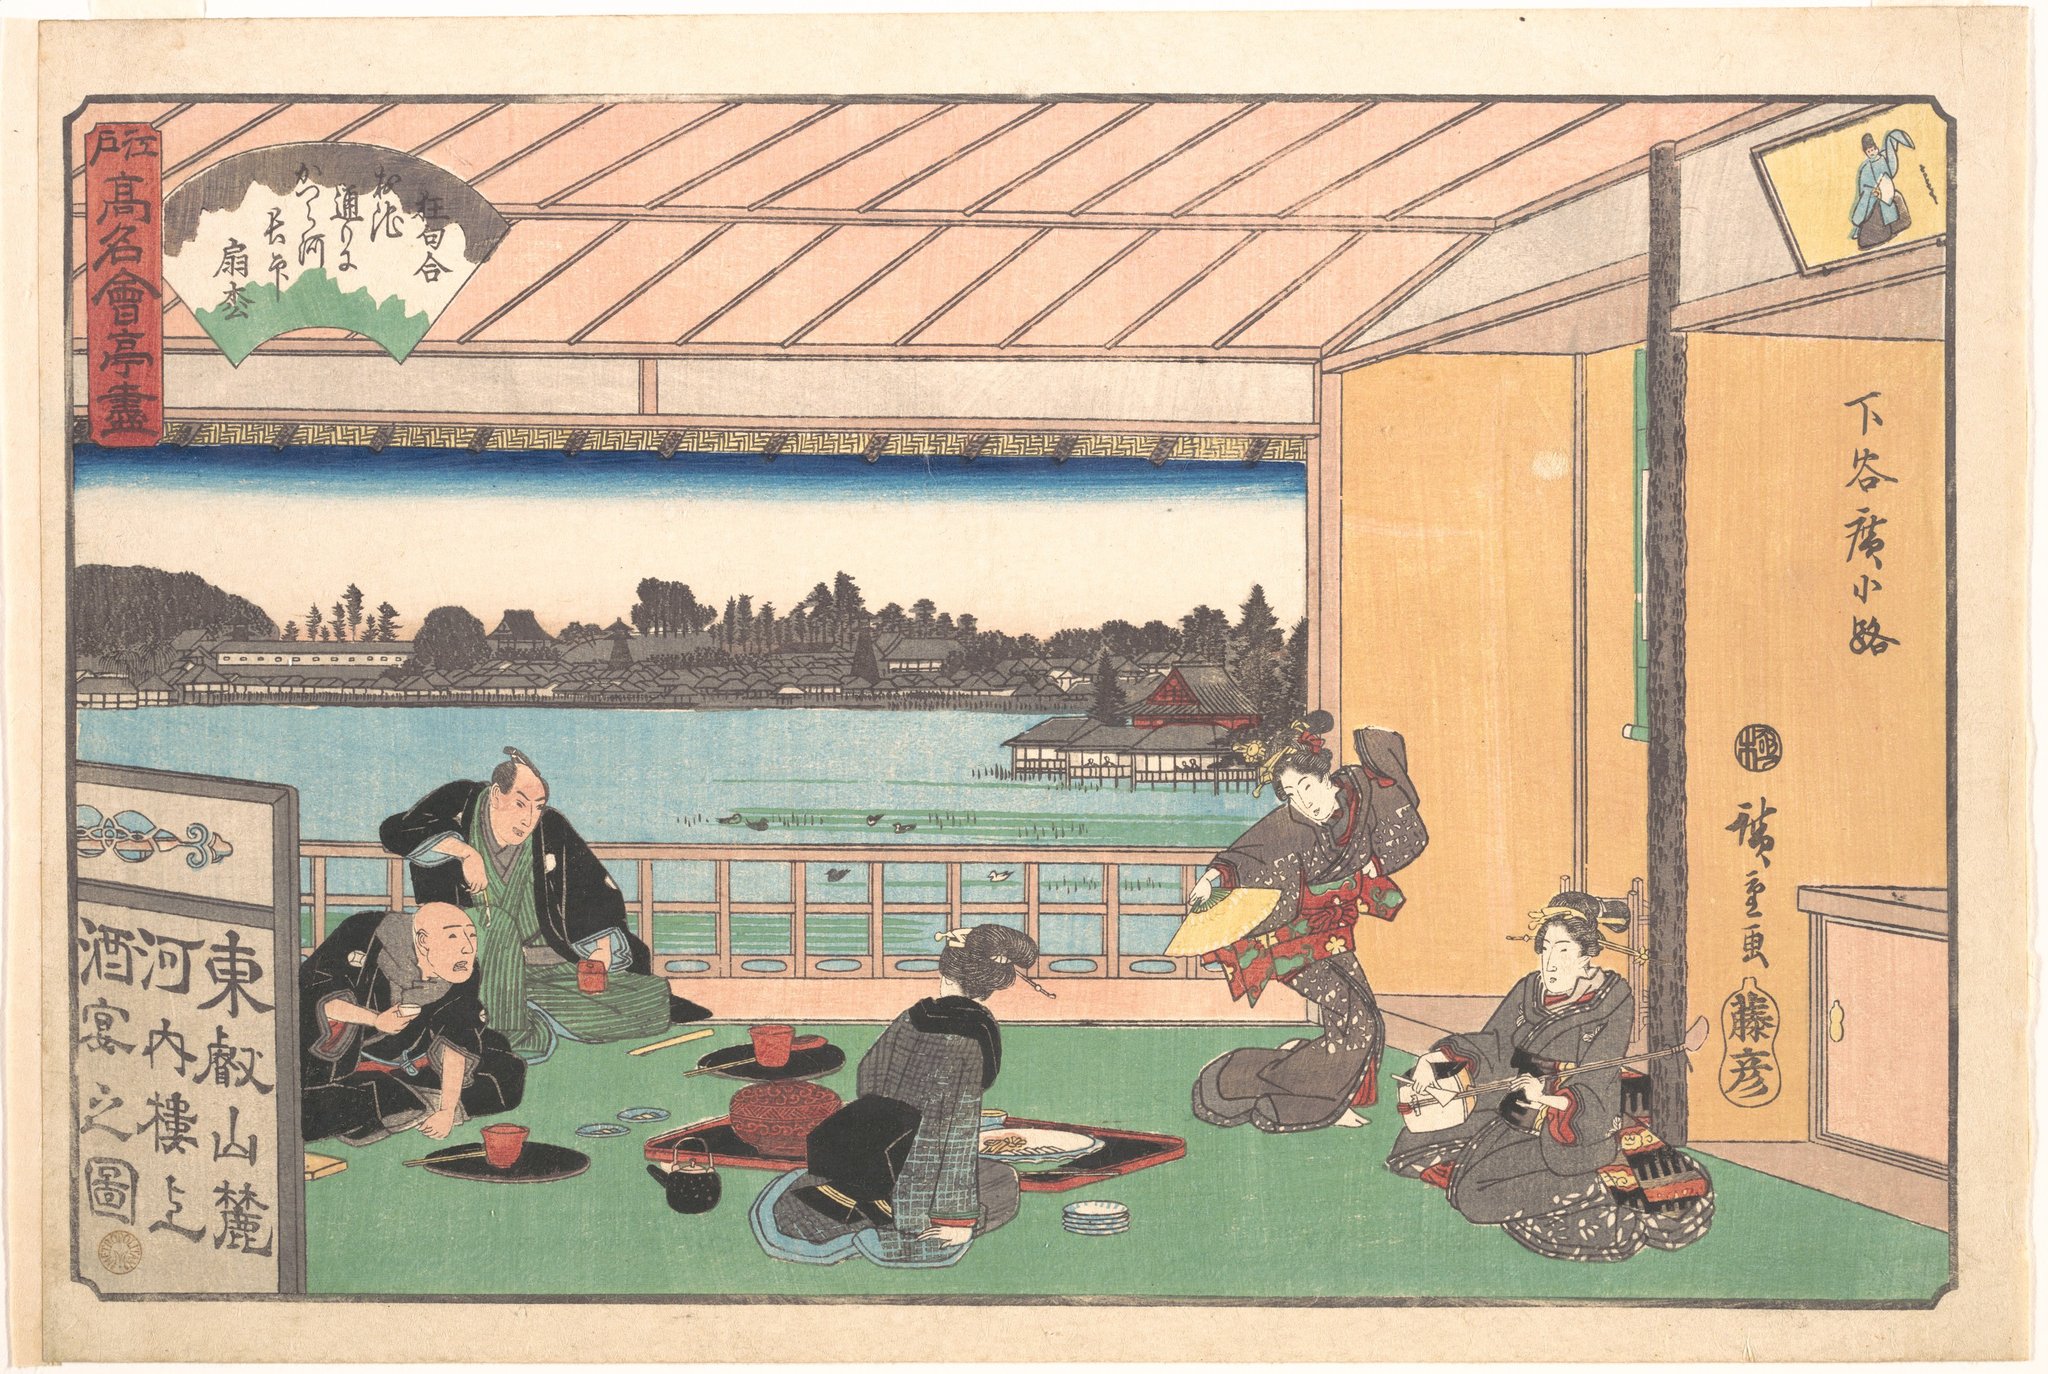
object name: print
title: Teahouse at Hirokōji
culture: japanese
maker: utagawa hiroshige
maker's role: artist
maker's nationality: japanese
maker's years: 1797-1858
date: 1835-1842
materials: ink, paper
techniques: woodblock print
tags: interiors,men,women,dancing